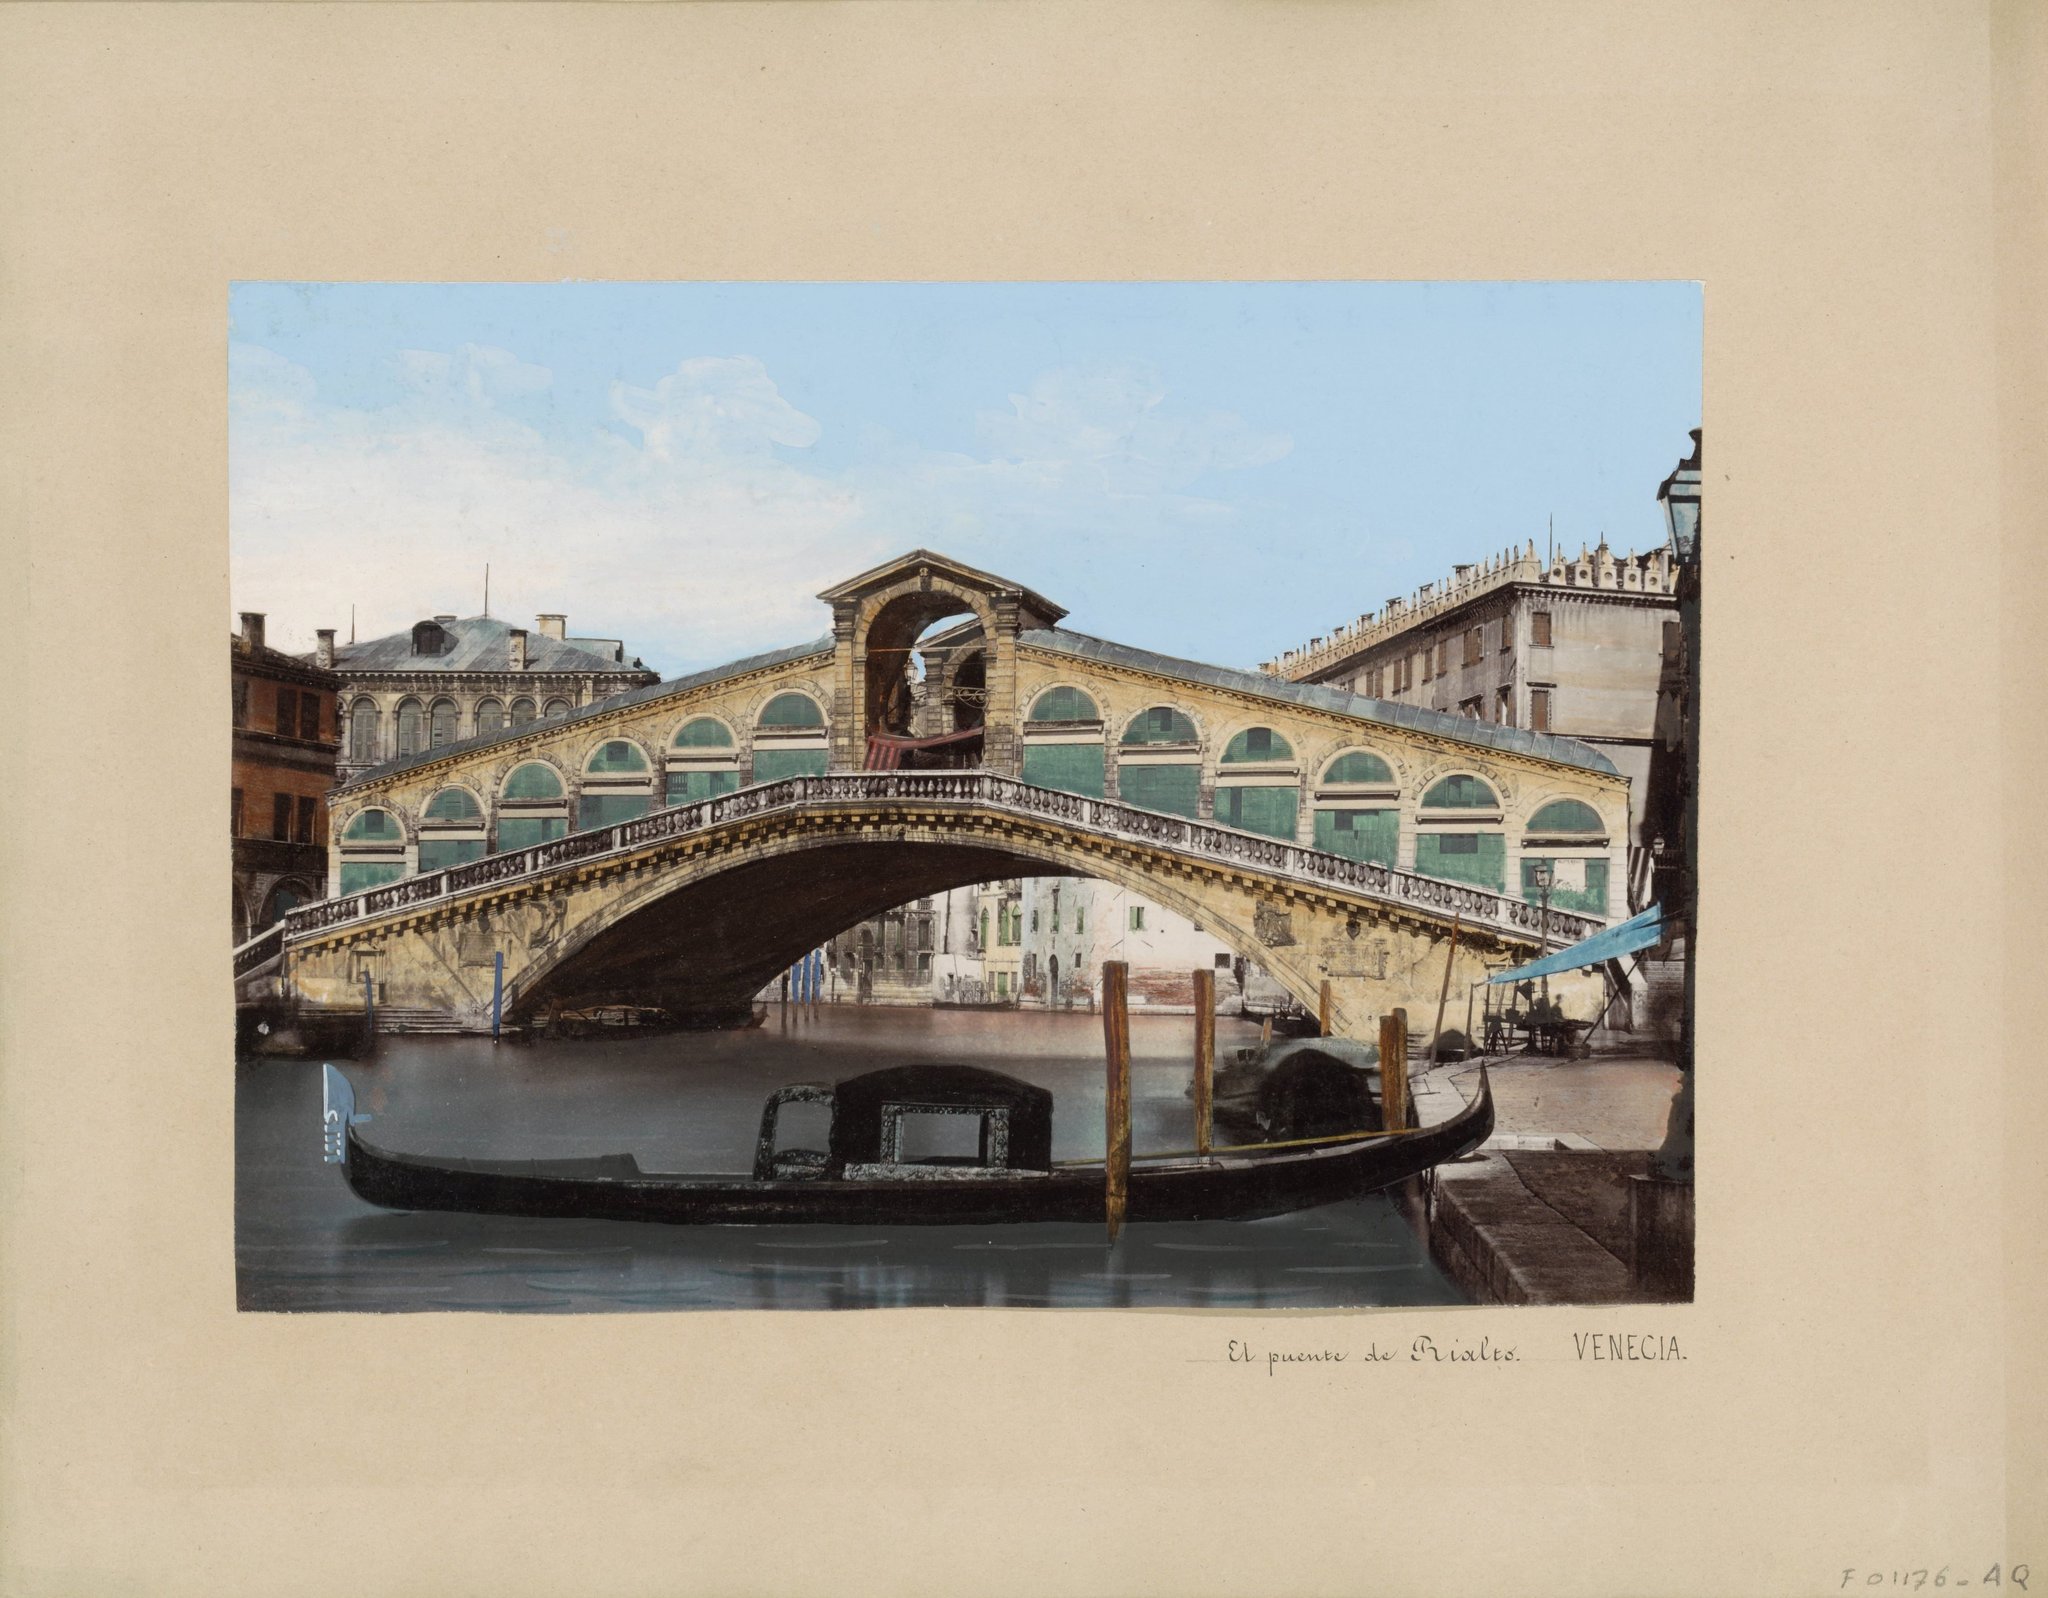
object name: photograph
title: Ponte Rialto in Venetië, op de voorgrond een gondel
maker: Anonymous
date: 1850-1876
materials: paint, photographic support, watercolor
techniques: albumen print, hand coloring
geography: venice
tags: travelling; tourism, bridge, gondola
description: Onderdeel van Reisalbum met foto's en tekeningen van Manuel Mayo 1876.